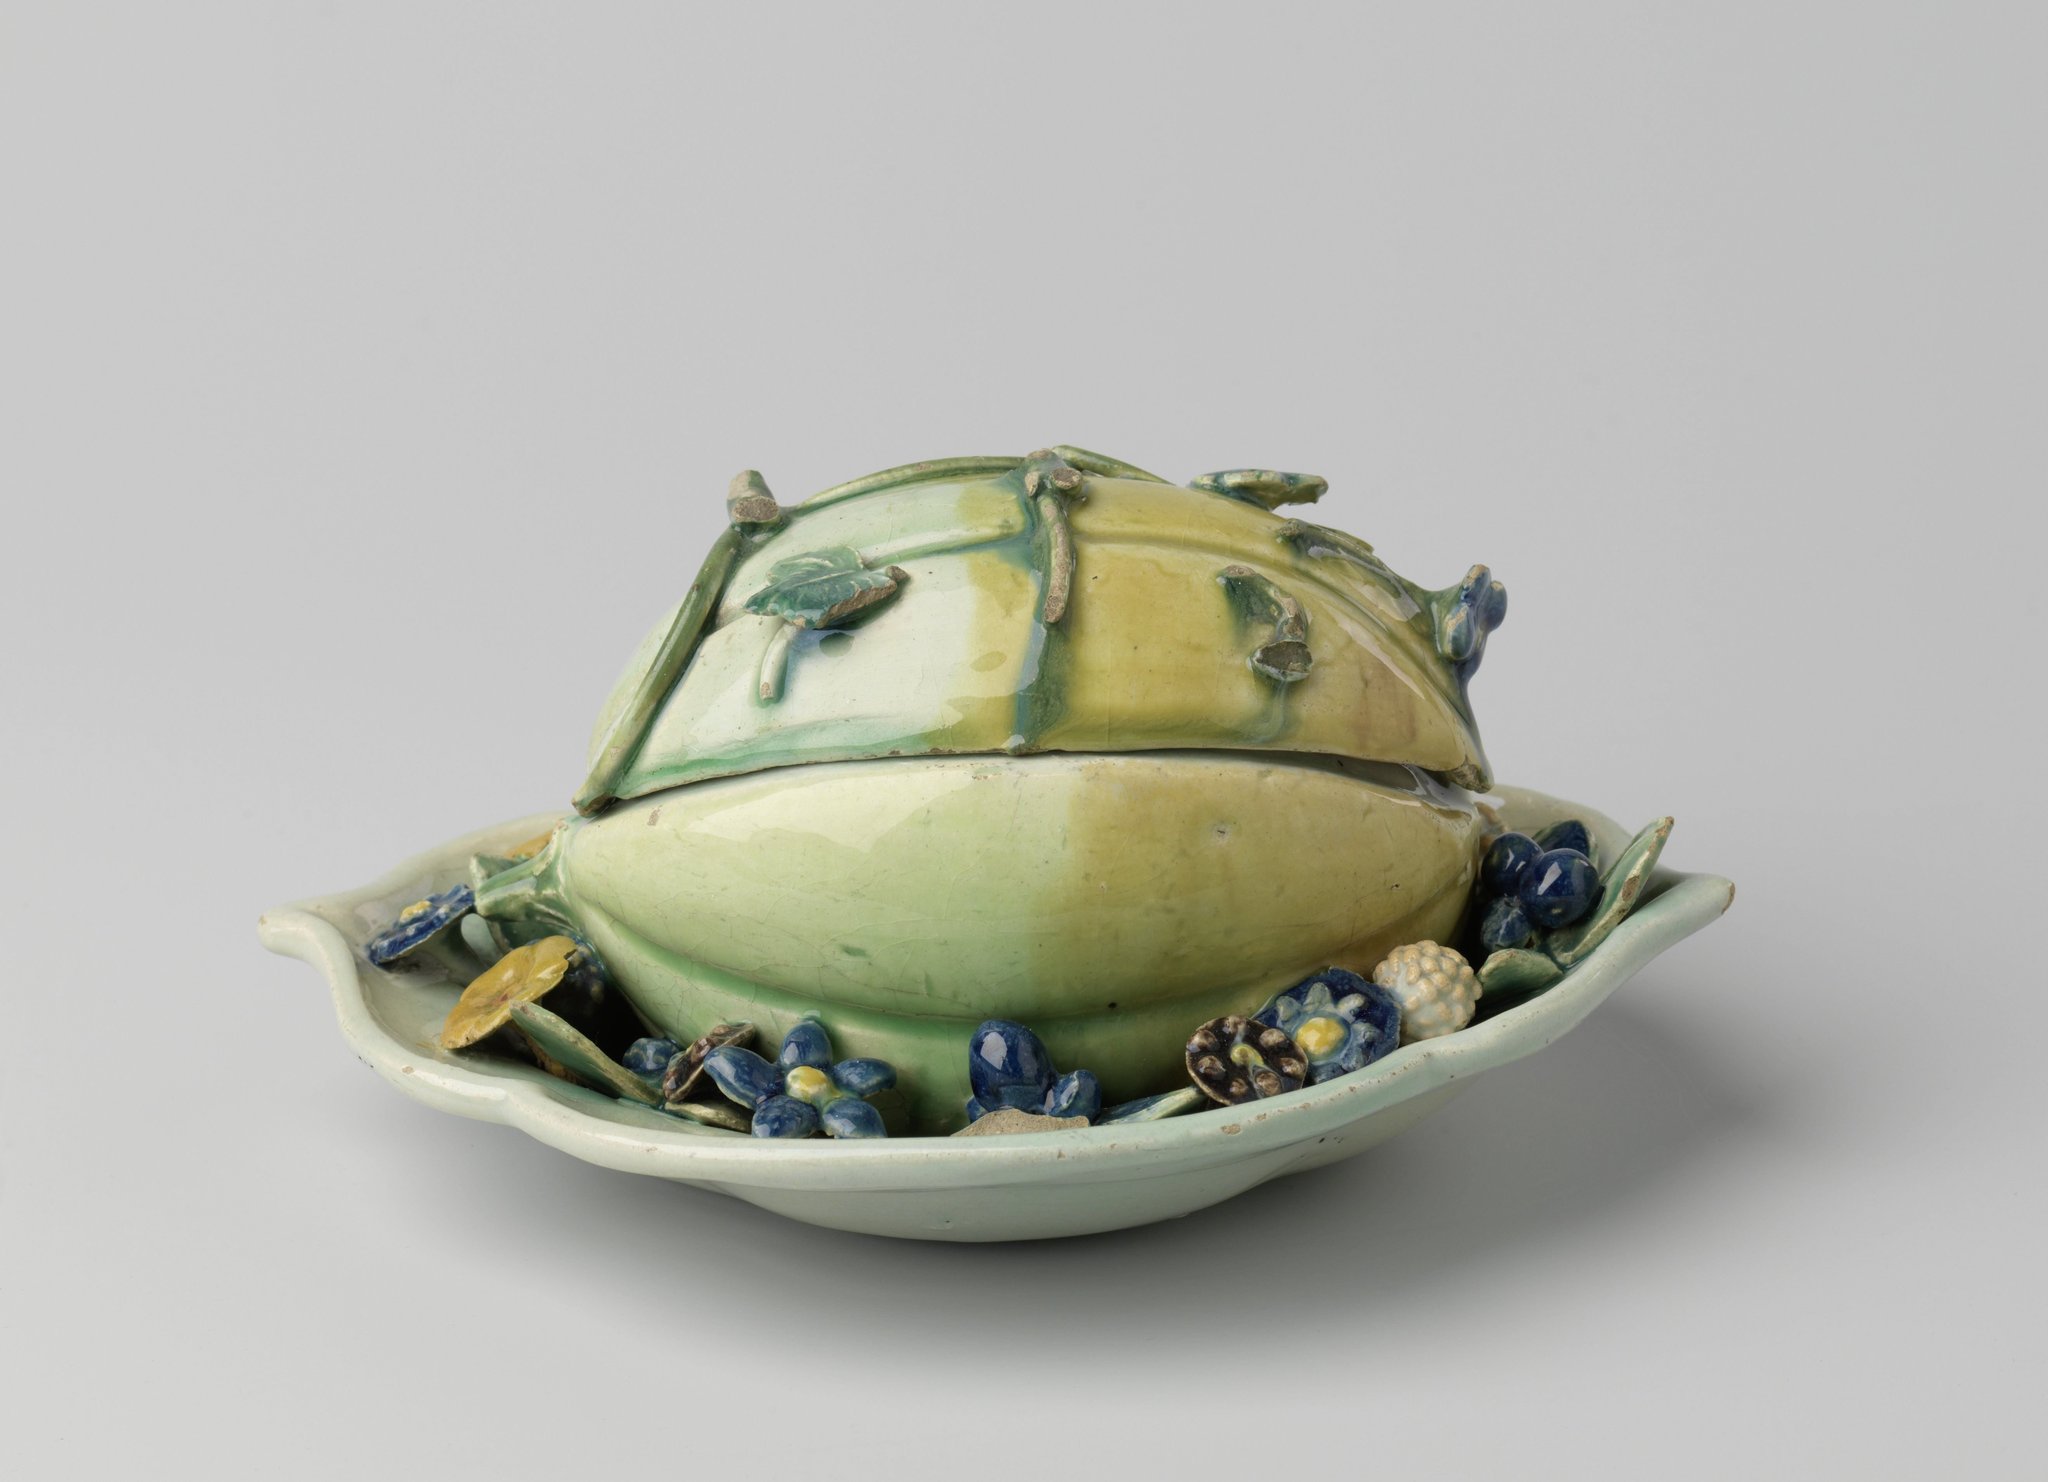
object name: butter dish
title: Botervloot in de vorm van een meloen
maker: arie blankers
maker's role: plateelbakker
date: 1755-1760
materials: earthenware, glaze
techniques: painted, polychromy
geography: amsterdam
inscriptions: mark: ‘AB(ineen)’, mark: ‘A B’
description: Botervloot van veelkleurig beschilderde faience, met een deksel. De botervloot heeft de vorm van een meloen. De botervloot is gemerkt en hoort bij een identieke botervloot met invnr. BK-NM-5018.